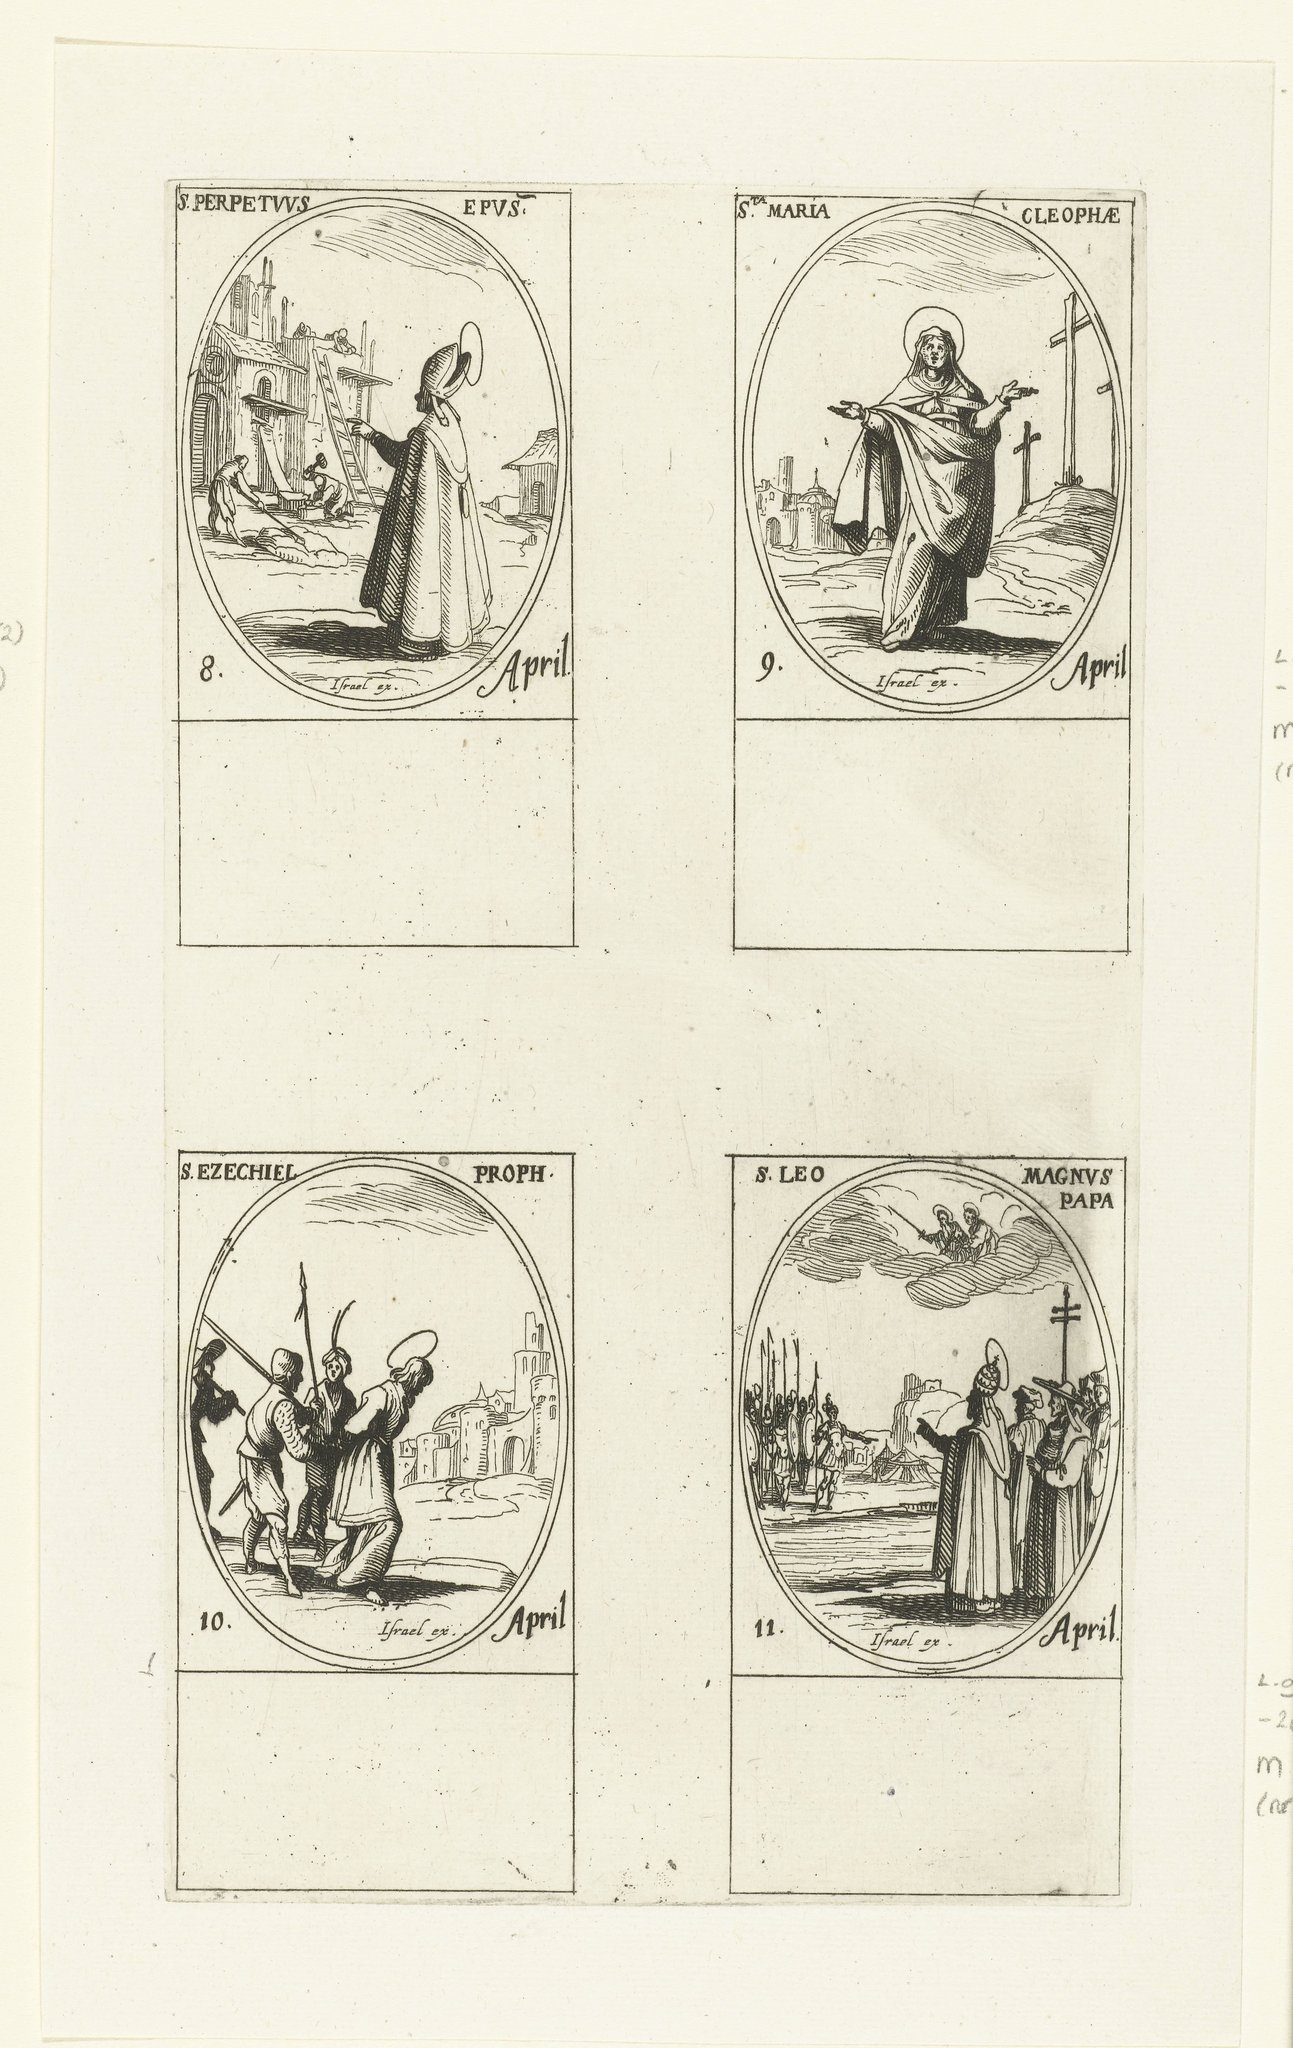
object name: print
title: Alle heiligen en de Christelijke feestdagen van het jaar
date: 1632-1636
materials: paper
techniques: etching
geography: paris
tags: mary kleophas, sister of the virgin mary, mother of james the less ('maria jacobi'); possible attributes: jar of ointment, ezekiel (not in biblical context); possible attributes: book or scroll, double wheel, pope leo the great meets attila outside the walls of rome, and points out to him the two apostles st. peter and st. paul, appearing in the sky as protectors of rome, male saints (with name)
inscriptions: collector's mark: Lugt 240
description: Blad met vier ovale voorstellingen, elk met opschrift en datum in het Latijn: linksboven de Heilige Perpetuus van Tours wijzend op de bouw van een kerk, rechtsboven de Heilige Maria van Klopas op Golgota, linksonder de Heilige Ezechiël die gebonden wordt weggevoerd, rechtsonder de Heilige paus Leo de Grote tegenover een legerleider en zijn soldaten. Deze prent is onderdeel van een serie prenten met voorstellingen van de heiligen en de christelijke feestdagen van het jaar. Er zijn steeds vier scènes van één plaat op één blad gedrukt. Inclusief bijbehorend titelblad en frontispice gaat het in totaal om 124 platen (490 voorstellingen). De drie platen met de laatste 12 scènes (de veranderlijke christelijke feestdagen) zijn in de derde staat versneden tot 12 kleine plaatjes, en met een apart titelblad uitgegeven.